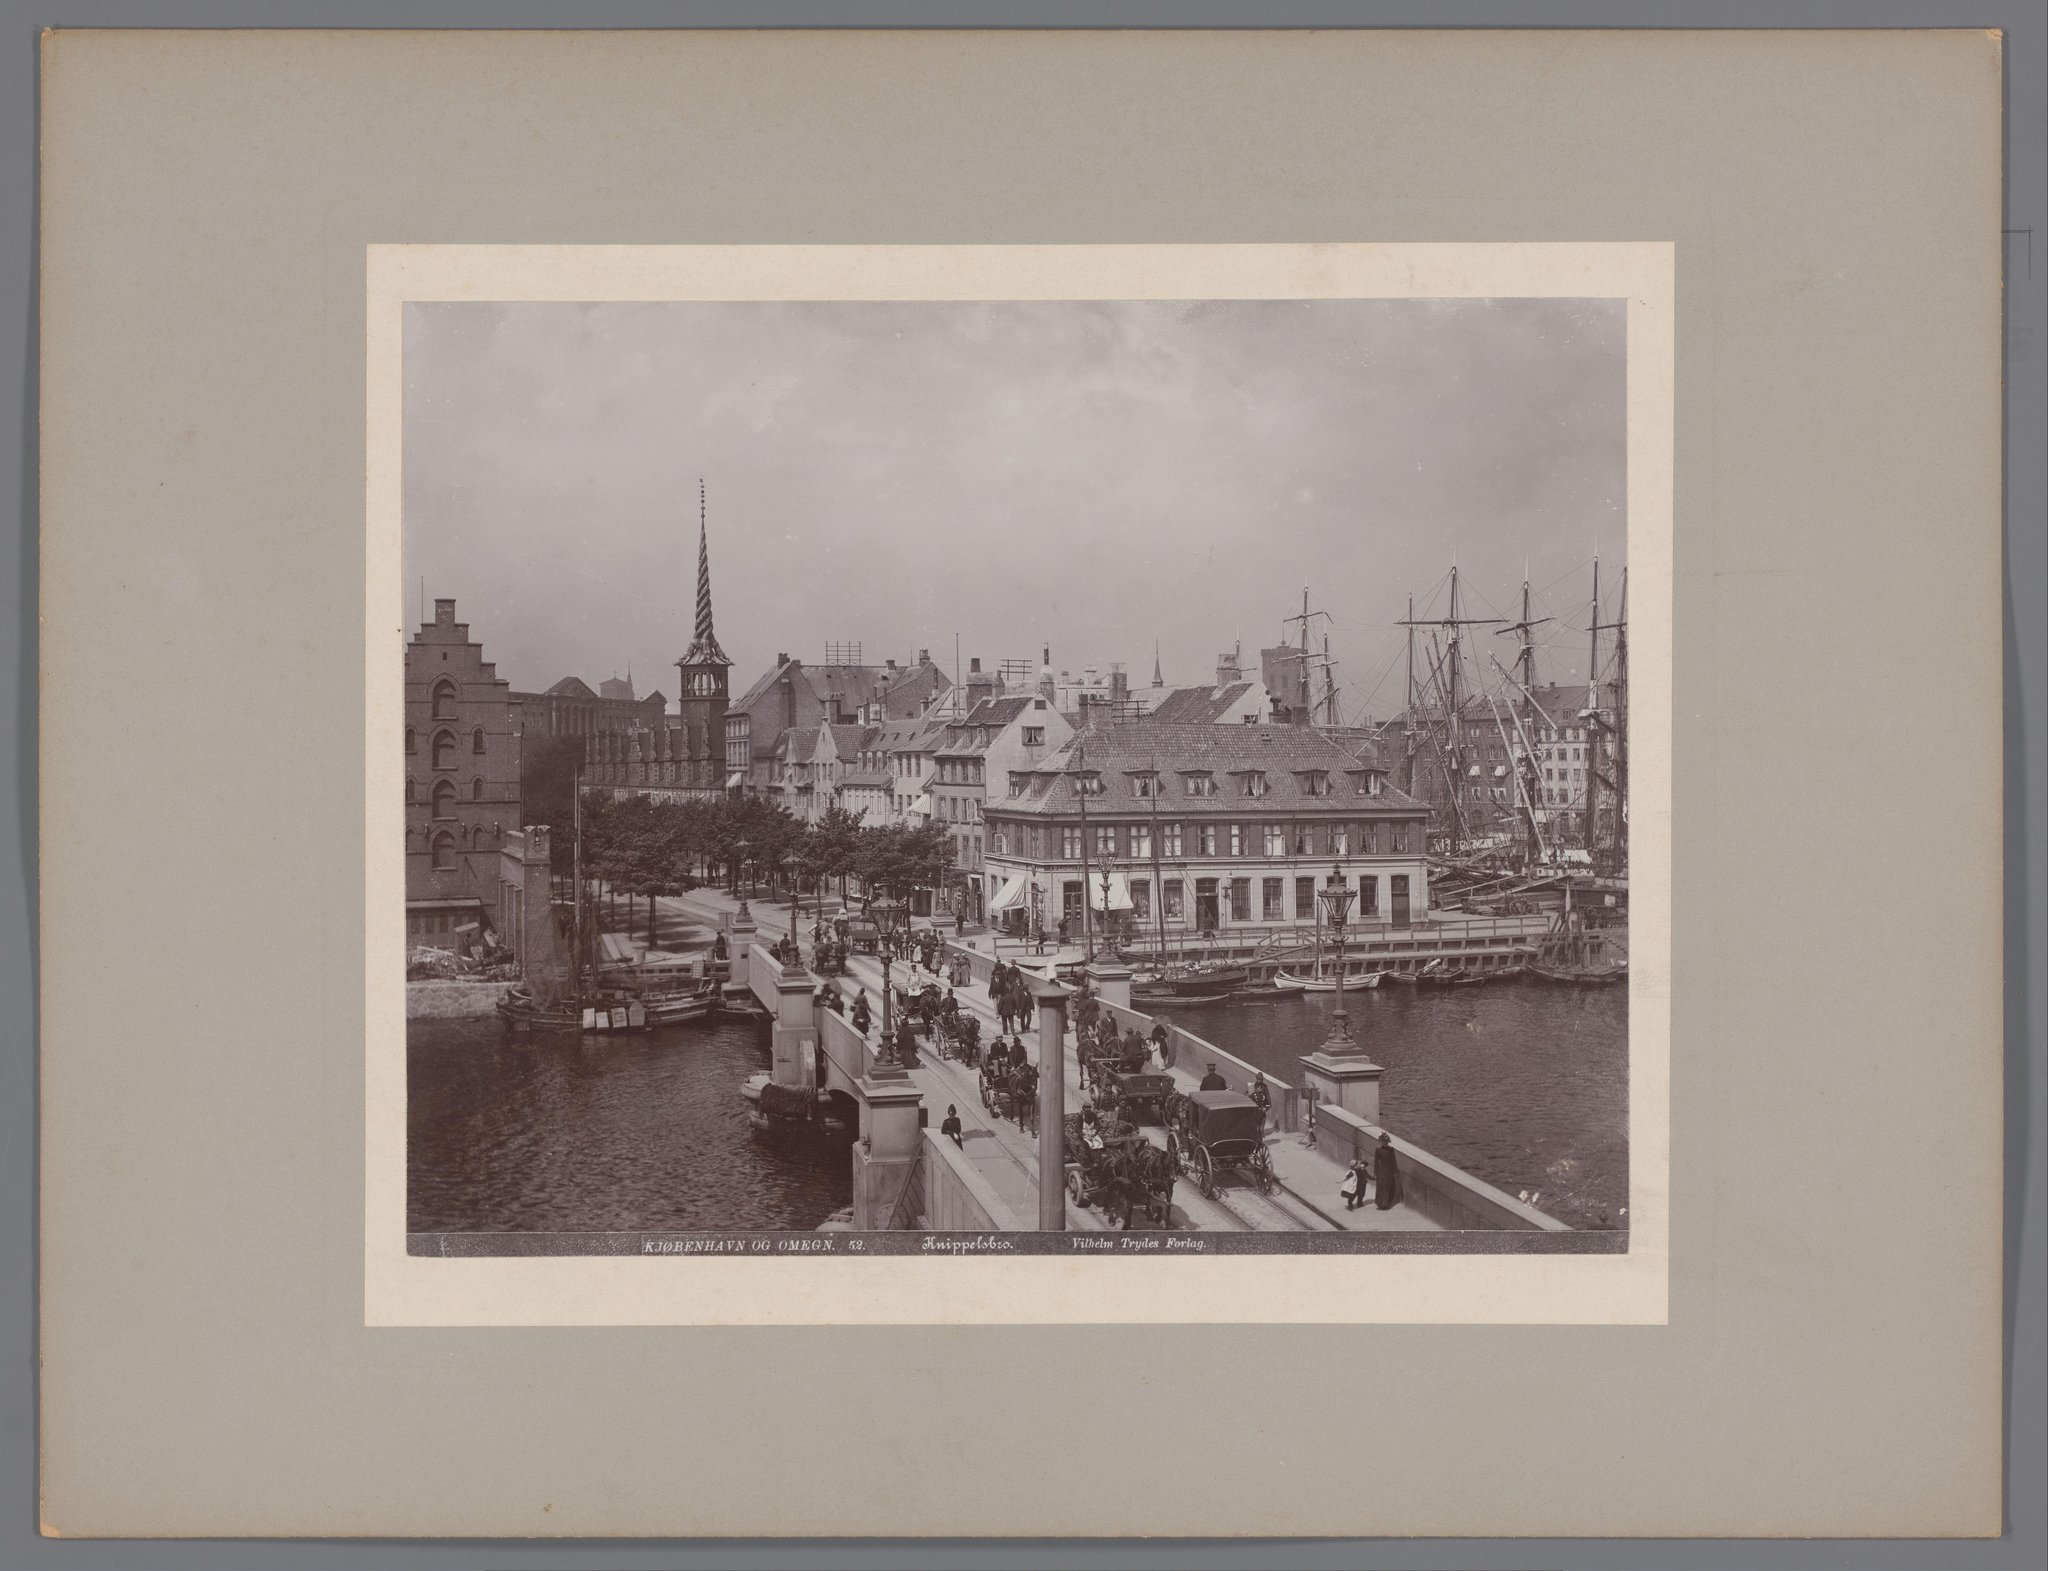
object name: photograph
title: Kjøbenhavn og Omegn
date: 1880-1910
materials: paper, cardboard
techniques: collodion silver print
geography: copenhagen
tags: bridge in city across river, canal, etc.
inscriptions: number: ‘52.’